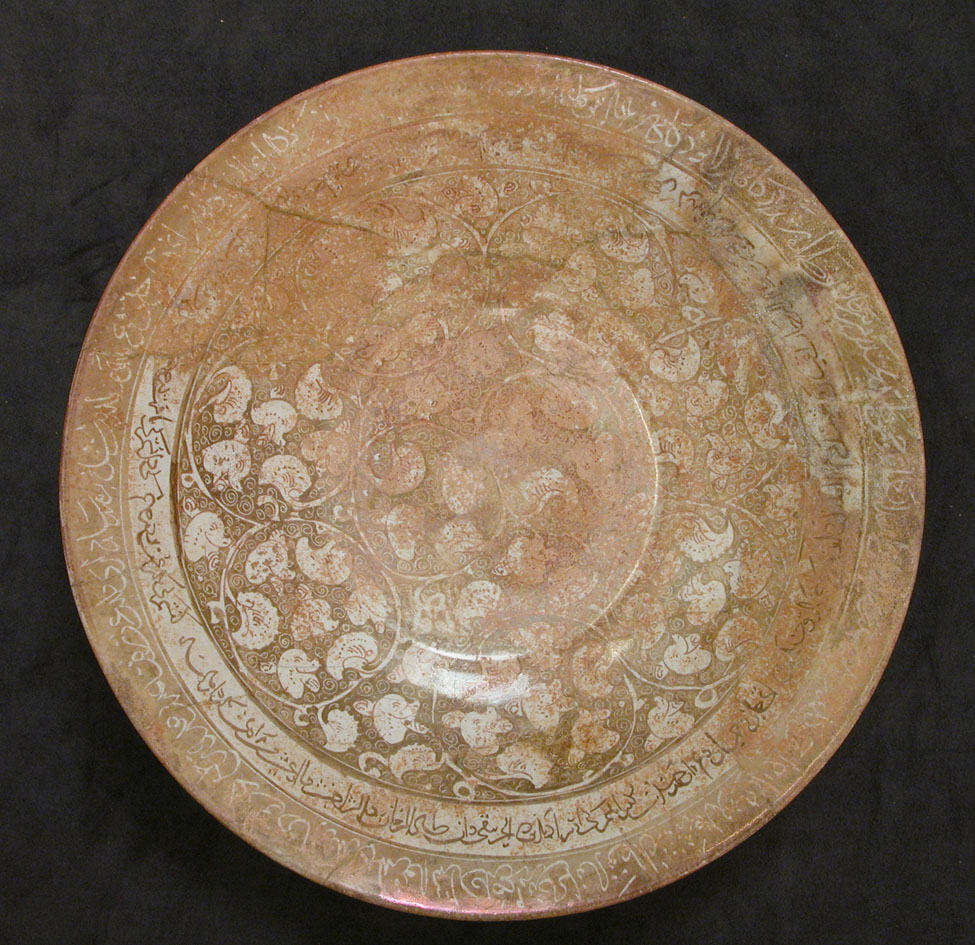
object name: bowl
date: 1201-1300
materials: stonepaste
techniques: glazing, luster painting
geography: iran